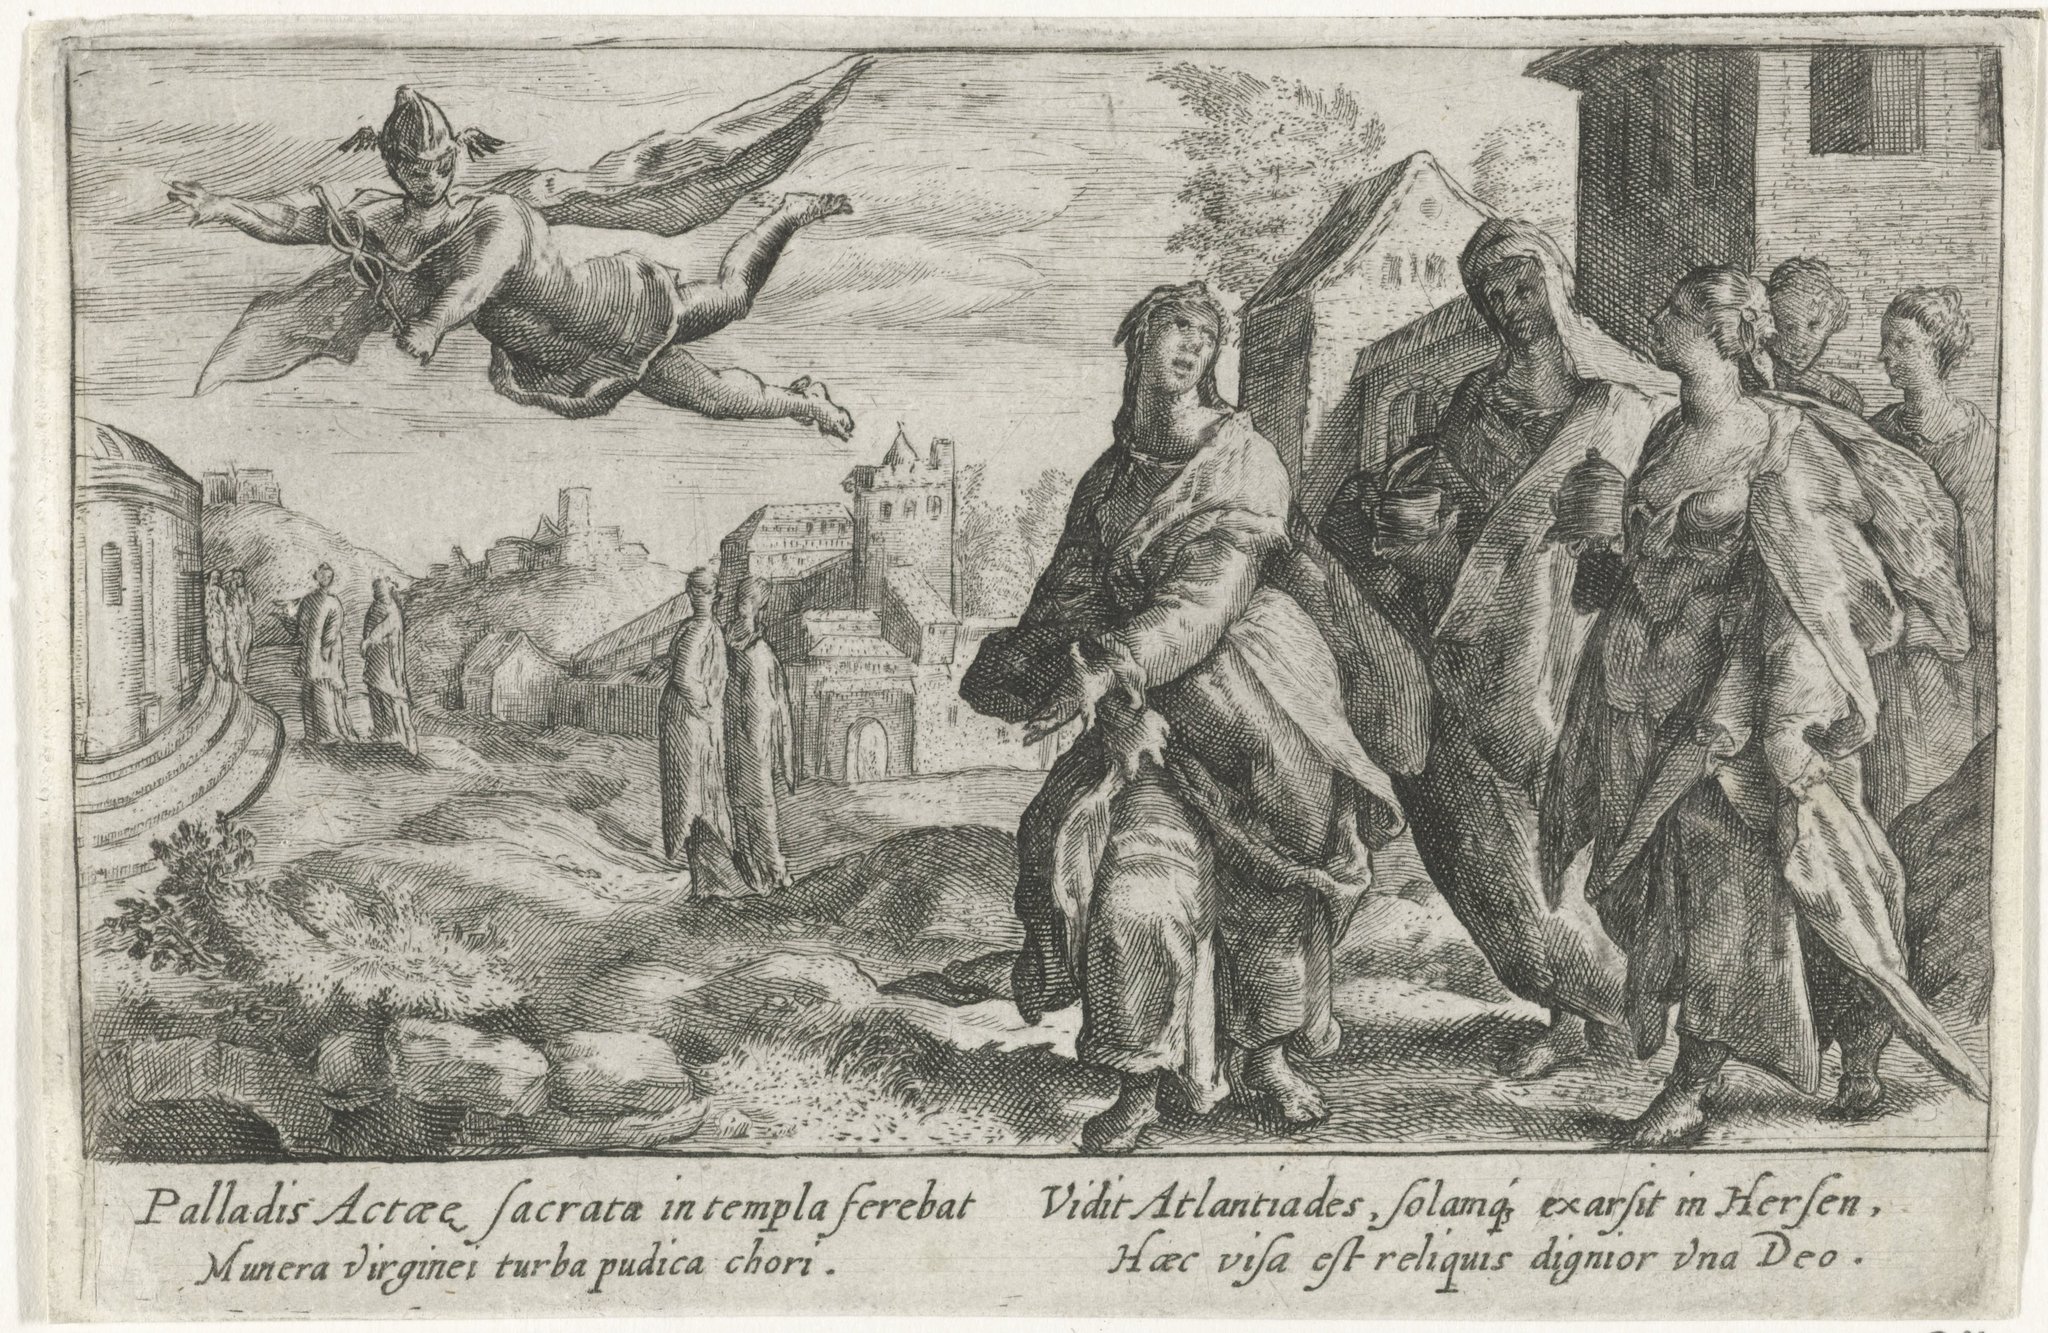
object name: print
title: Mercurius bespiedt drie zussen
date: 1602-1607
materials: paper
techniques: engraving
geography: cologne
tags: mercury falls in love with herse, when seeing her and her companions carry baskets full of flowers to the temple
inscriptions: collector's mark: Lugt 2228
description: Drie zussen brengen manden naar de tempel van Minerva en worden door Mercurius bespied. Hij werd direct verliefd op Herse, de mooiste van de drie. In de marge een vierregelig onderschrift, in twee kolommen, in het Latijn.